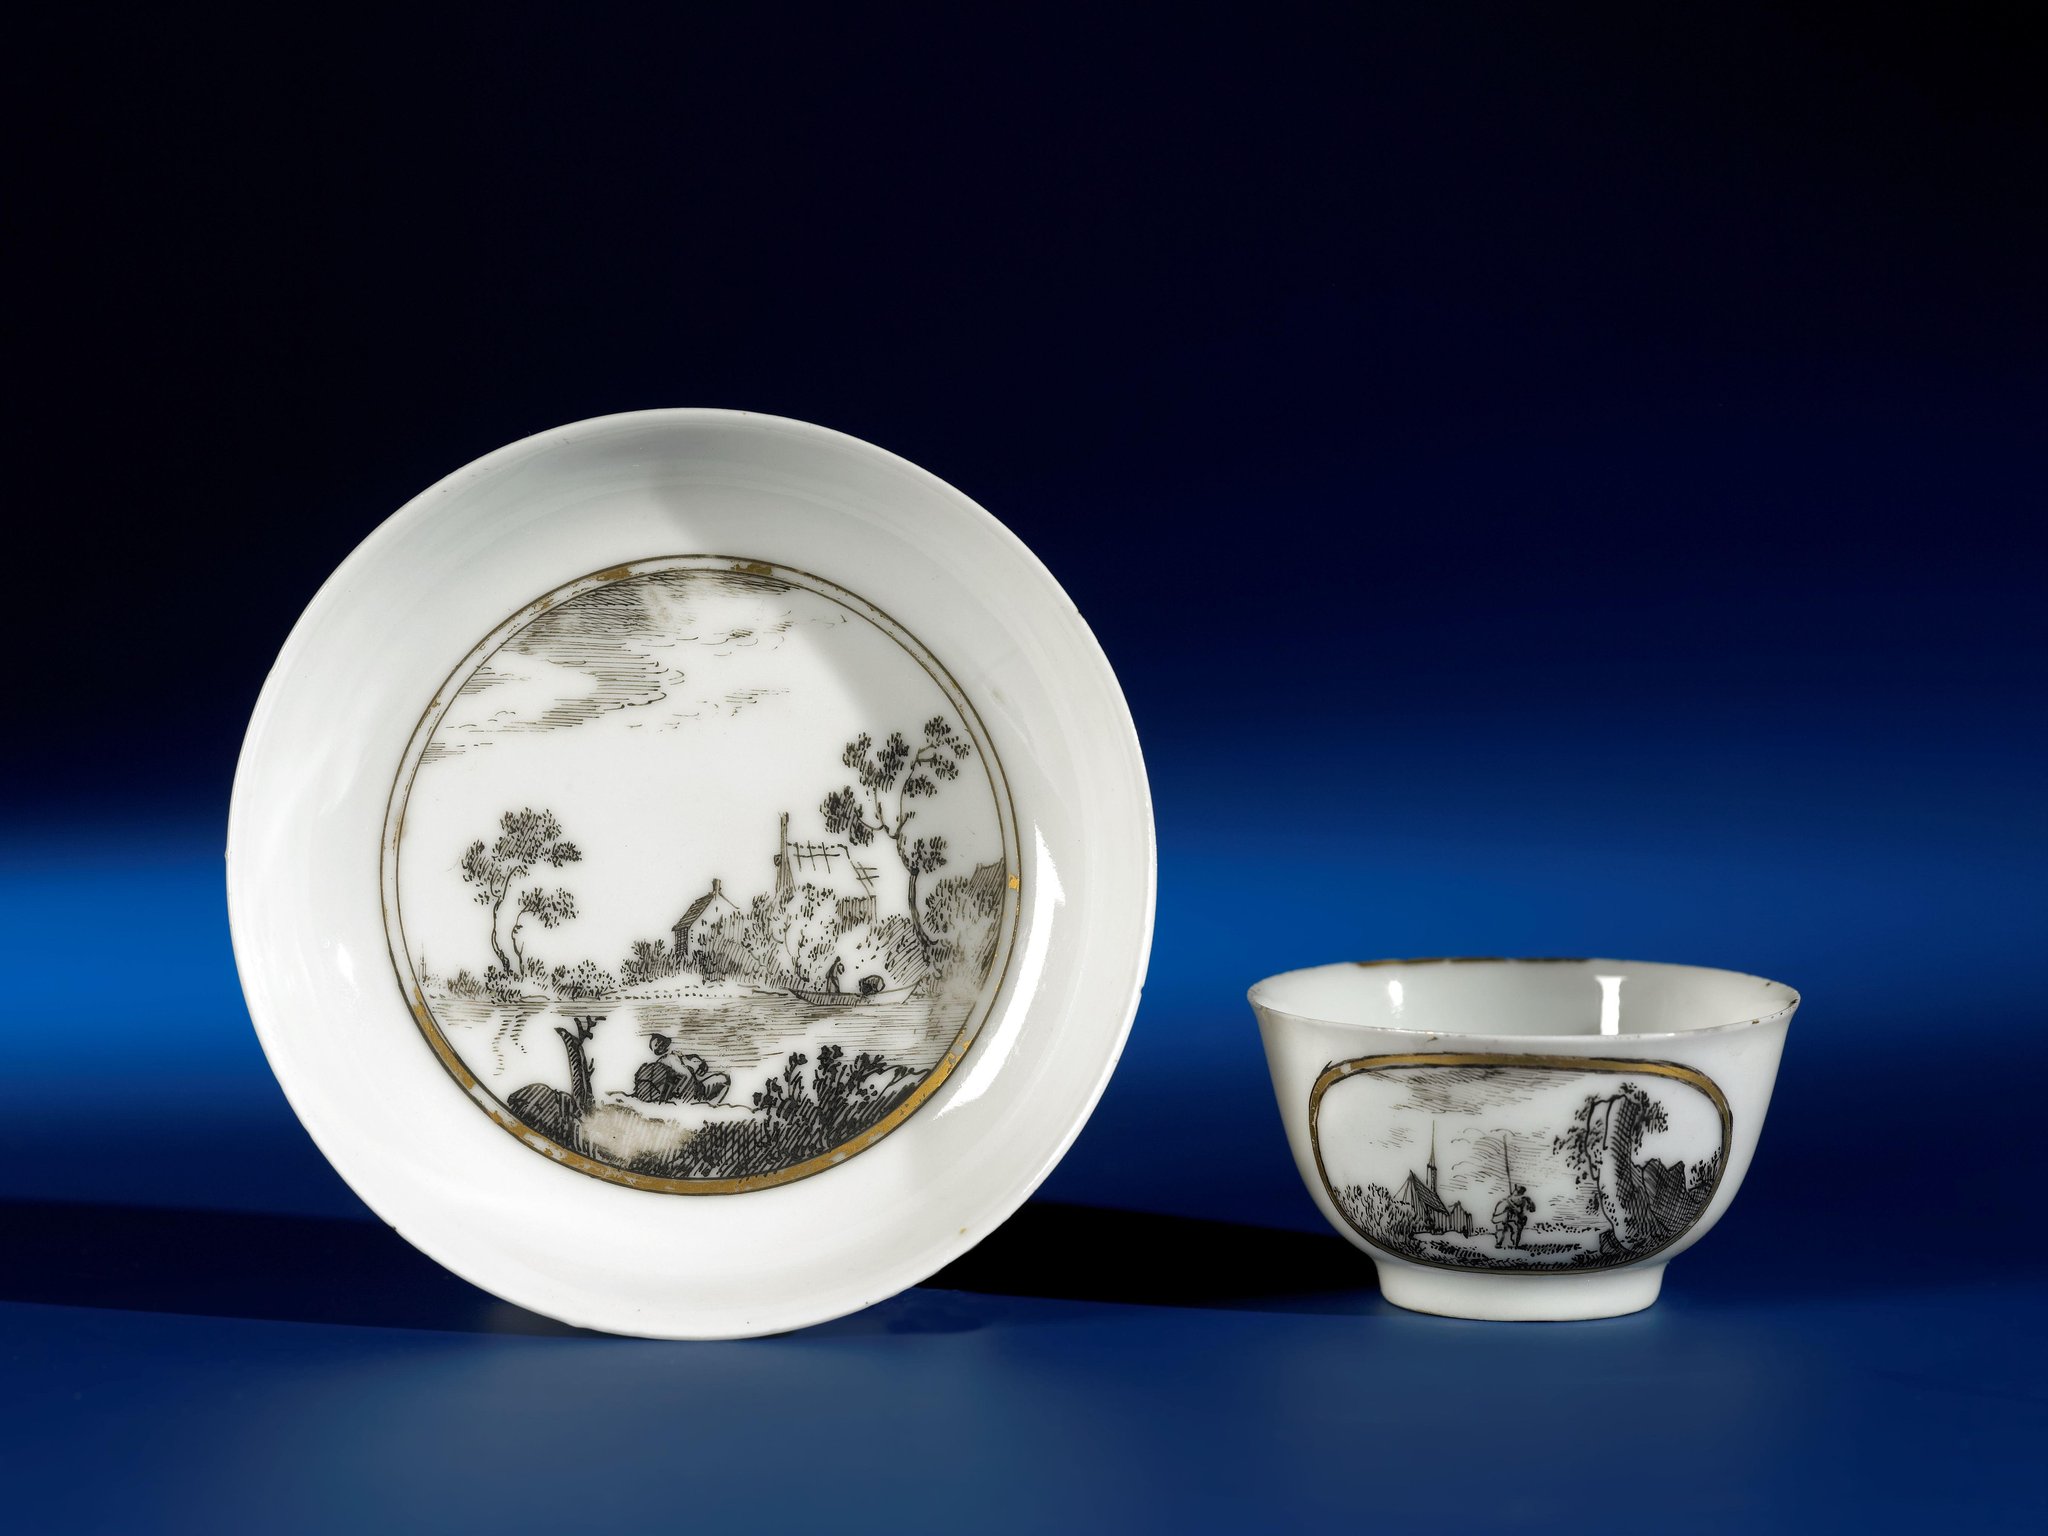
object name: cup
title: Bell-shaped cup with Dutch landschapes in medallions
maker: Anonymous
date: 1750-1774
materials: glaze, gold, paint, porcelain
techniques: firing, gilding, turning, vitrification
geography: china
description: Klokvormige kop van porselein beschilderd op het glazuur in zwart en goud. Op de kop met tweemaal een Europees landschap met bomen en personen in een ovaal medaillon; op de bodem een huis tussen bomen achter een heuvel. Een barst in de wand van de kop. Mogelijk in Europa gedecoreerd. Europese voorstellingen in encre de Chine.